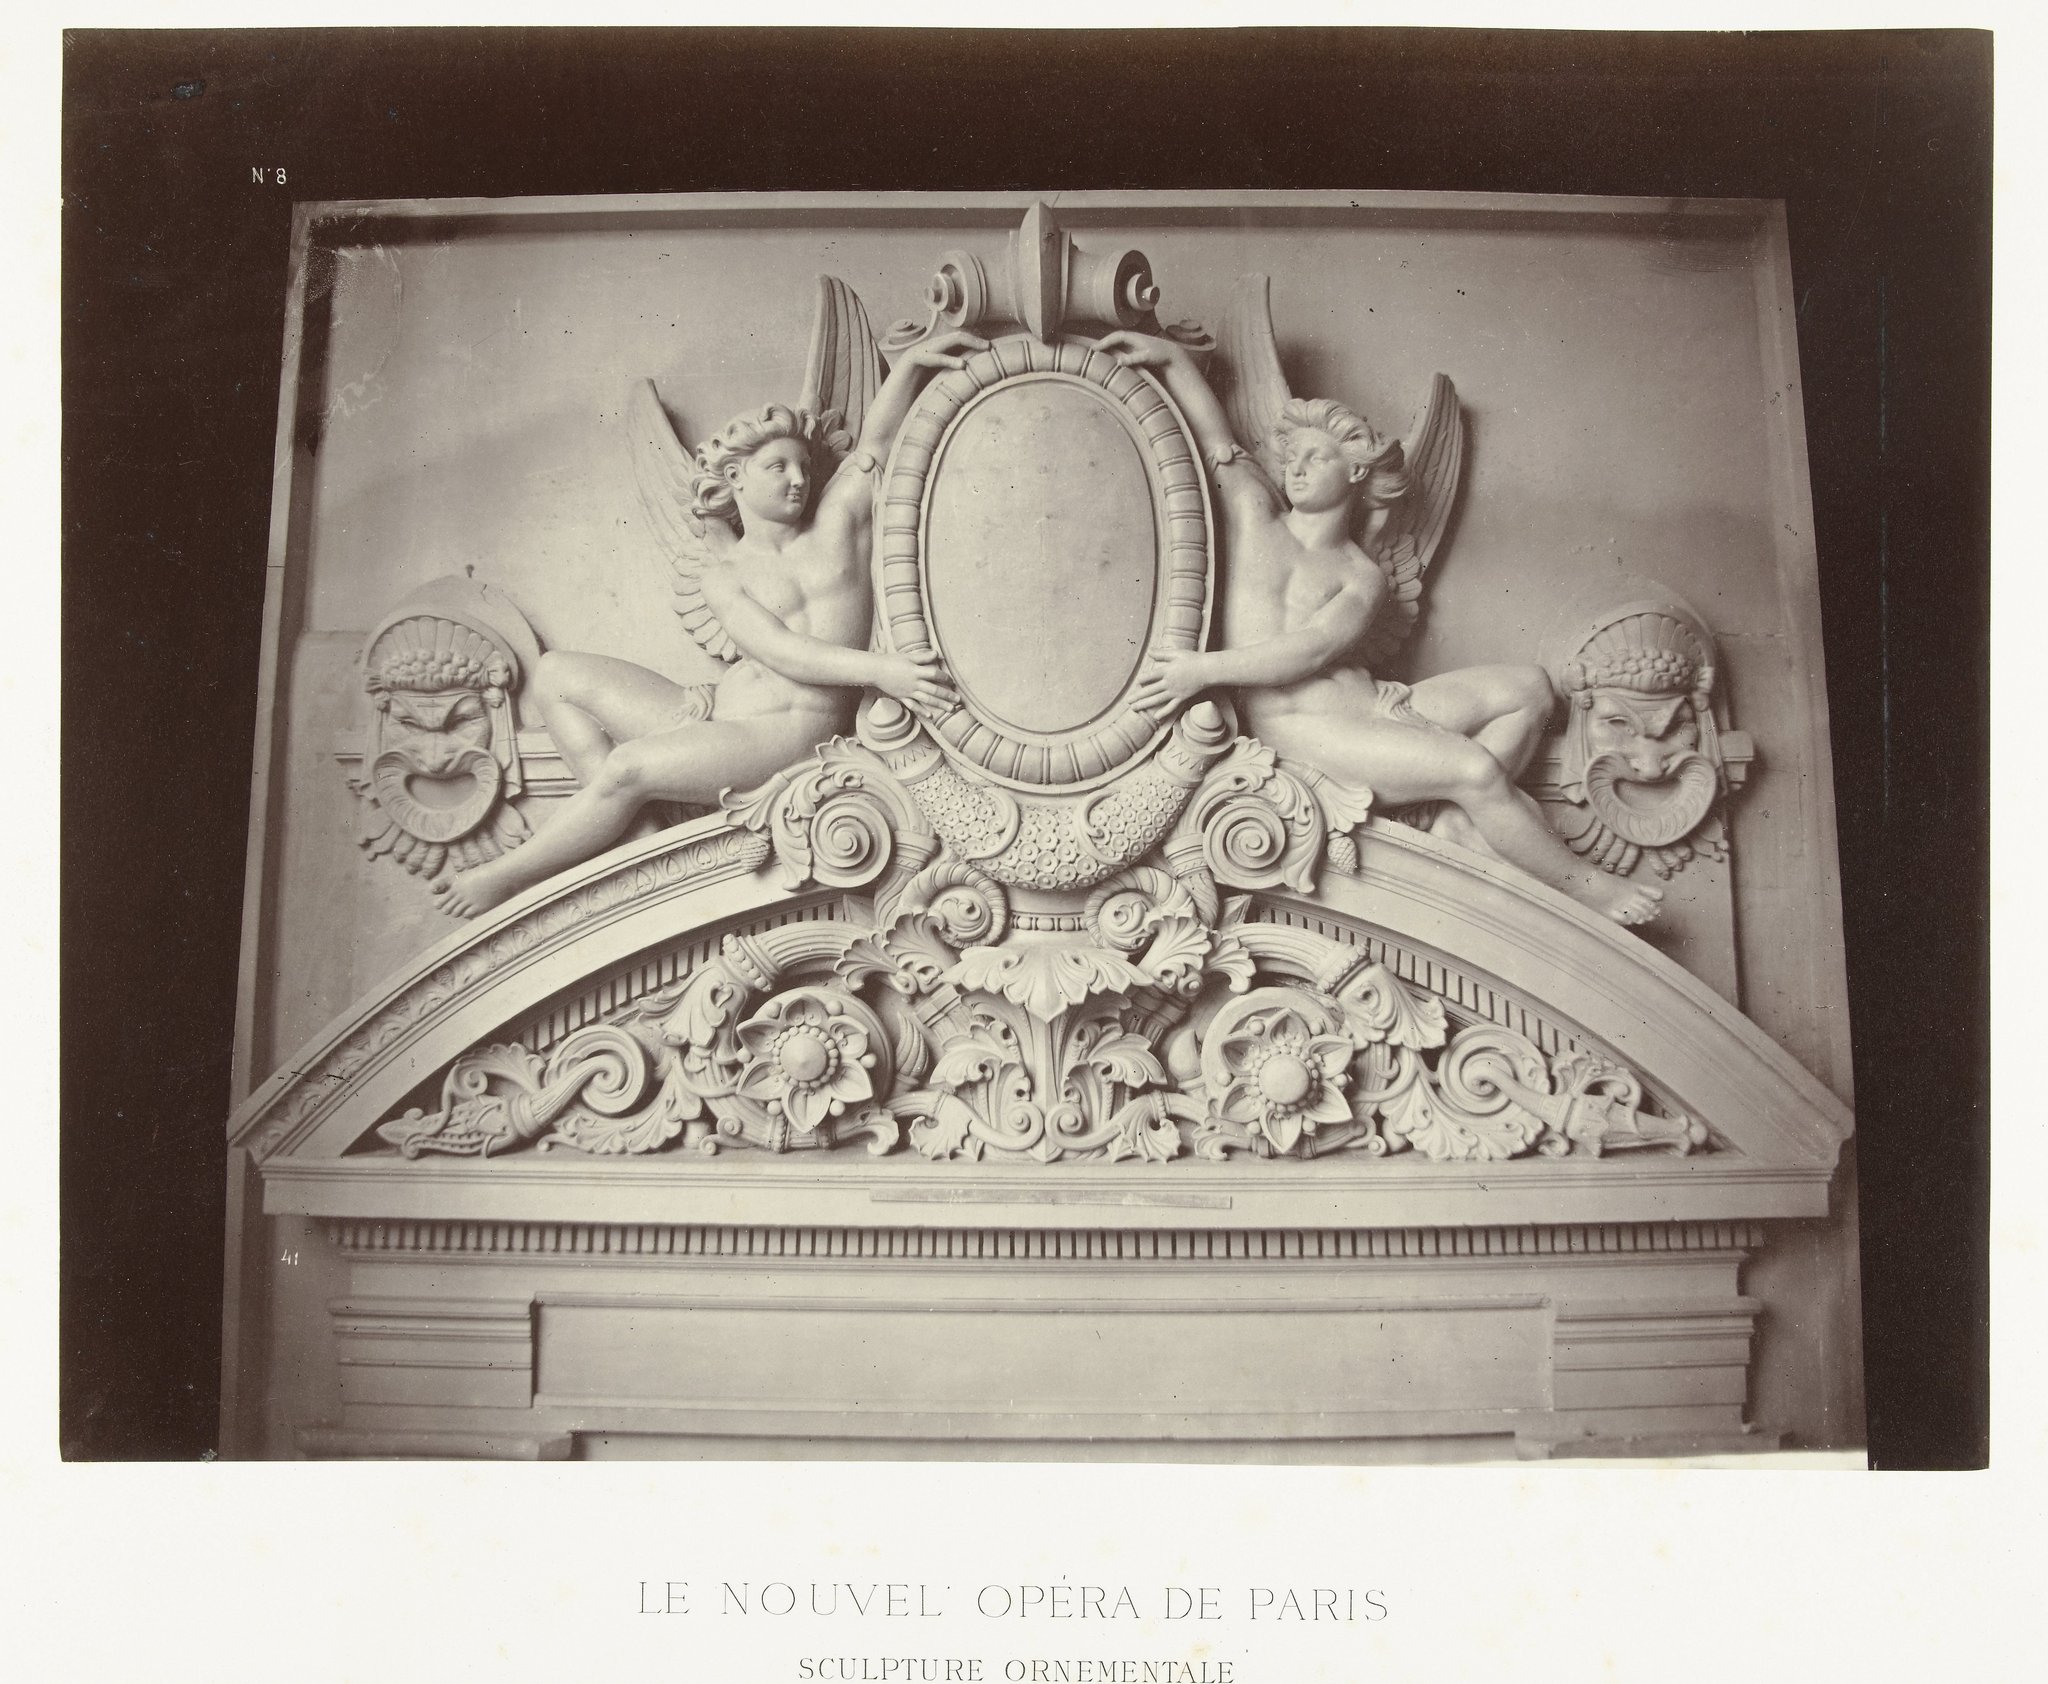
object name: photograph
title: Le Nouvel Opéra de Paris met 50 foto's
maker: louis-emile durandelle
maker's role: fotograaf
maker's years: 1839-1917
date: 1878-1881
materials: photographic support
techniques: albumen print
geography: paris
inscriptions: number: ‘8’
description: bij boek in Bibliotheek RMA, Zie Frizot, pp. 217-223, vgl G. Vicaire, Manuel de l'amateur de livres du XIXe siècle, vol. 3, column 870.